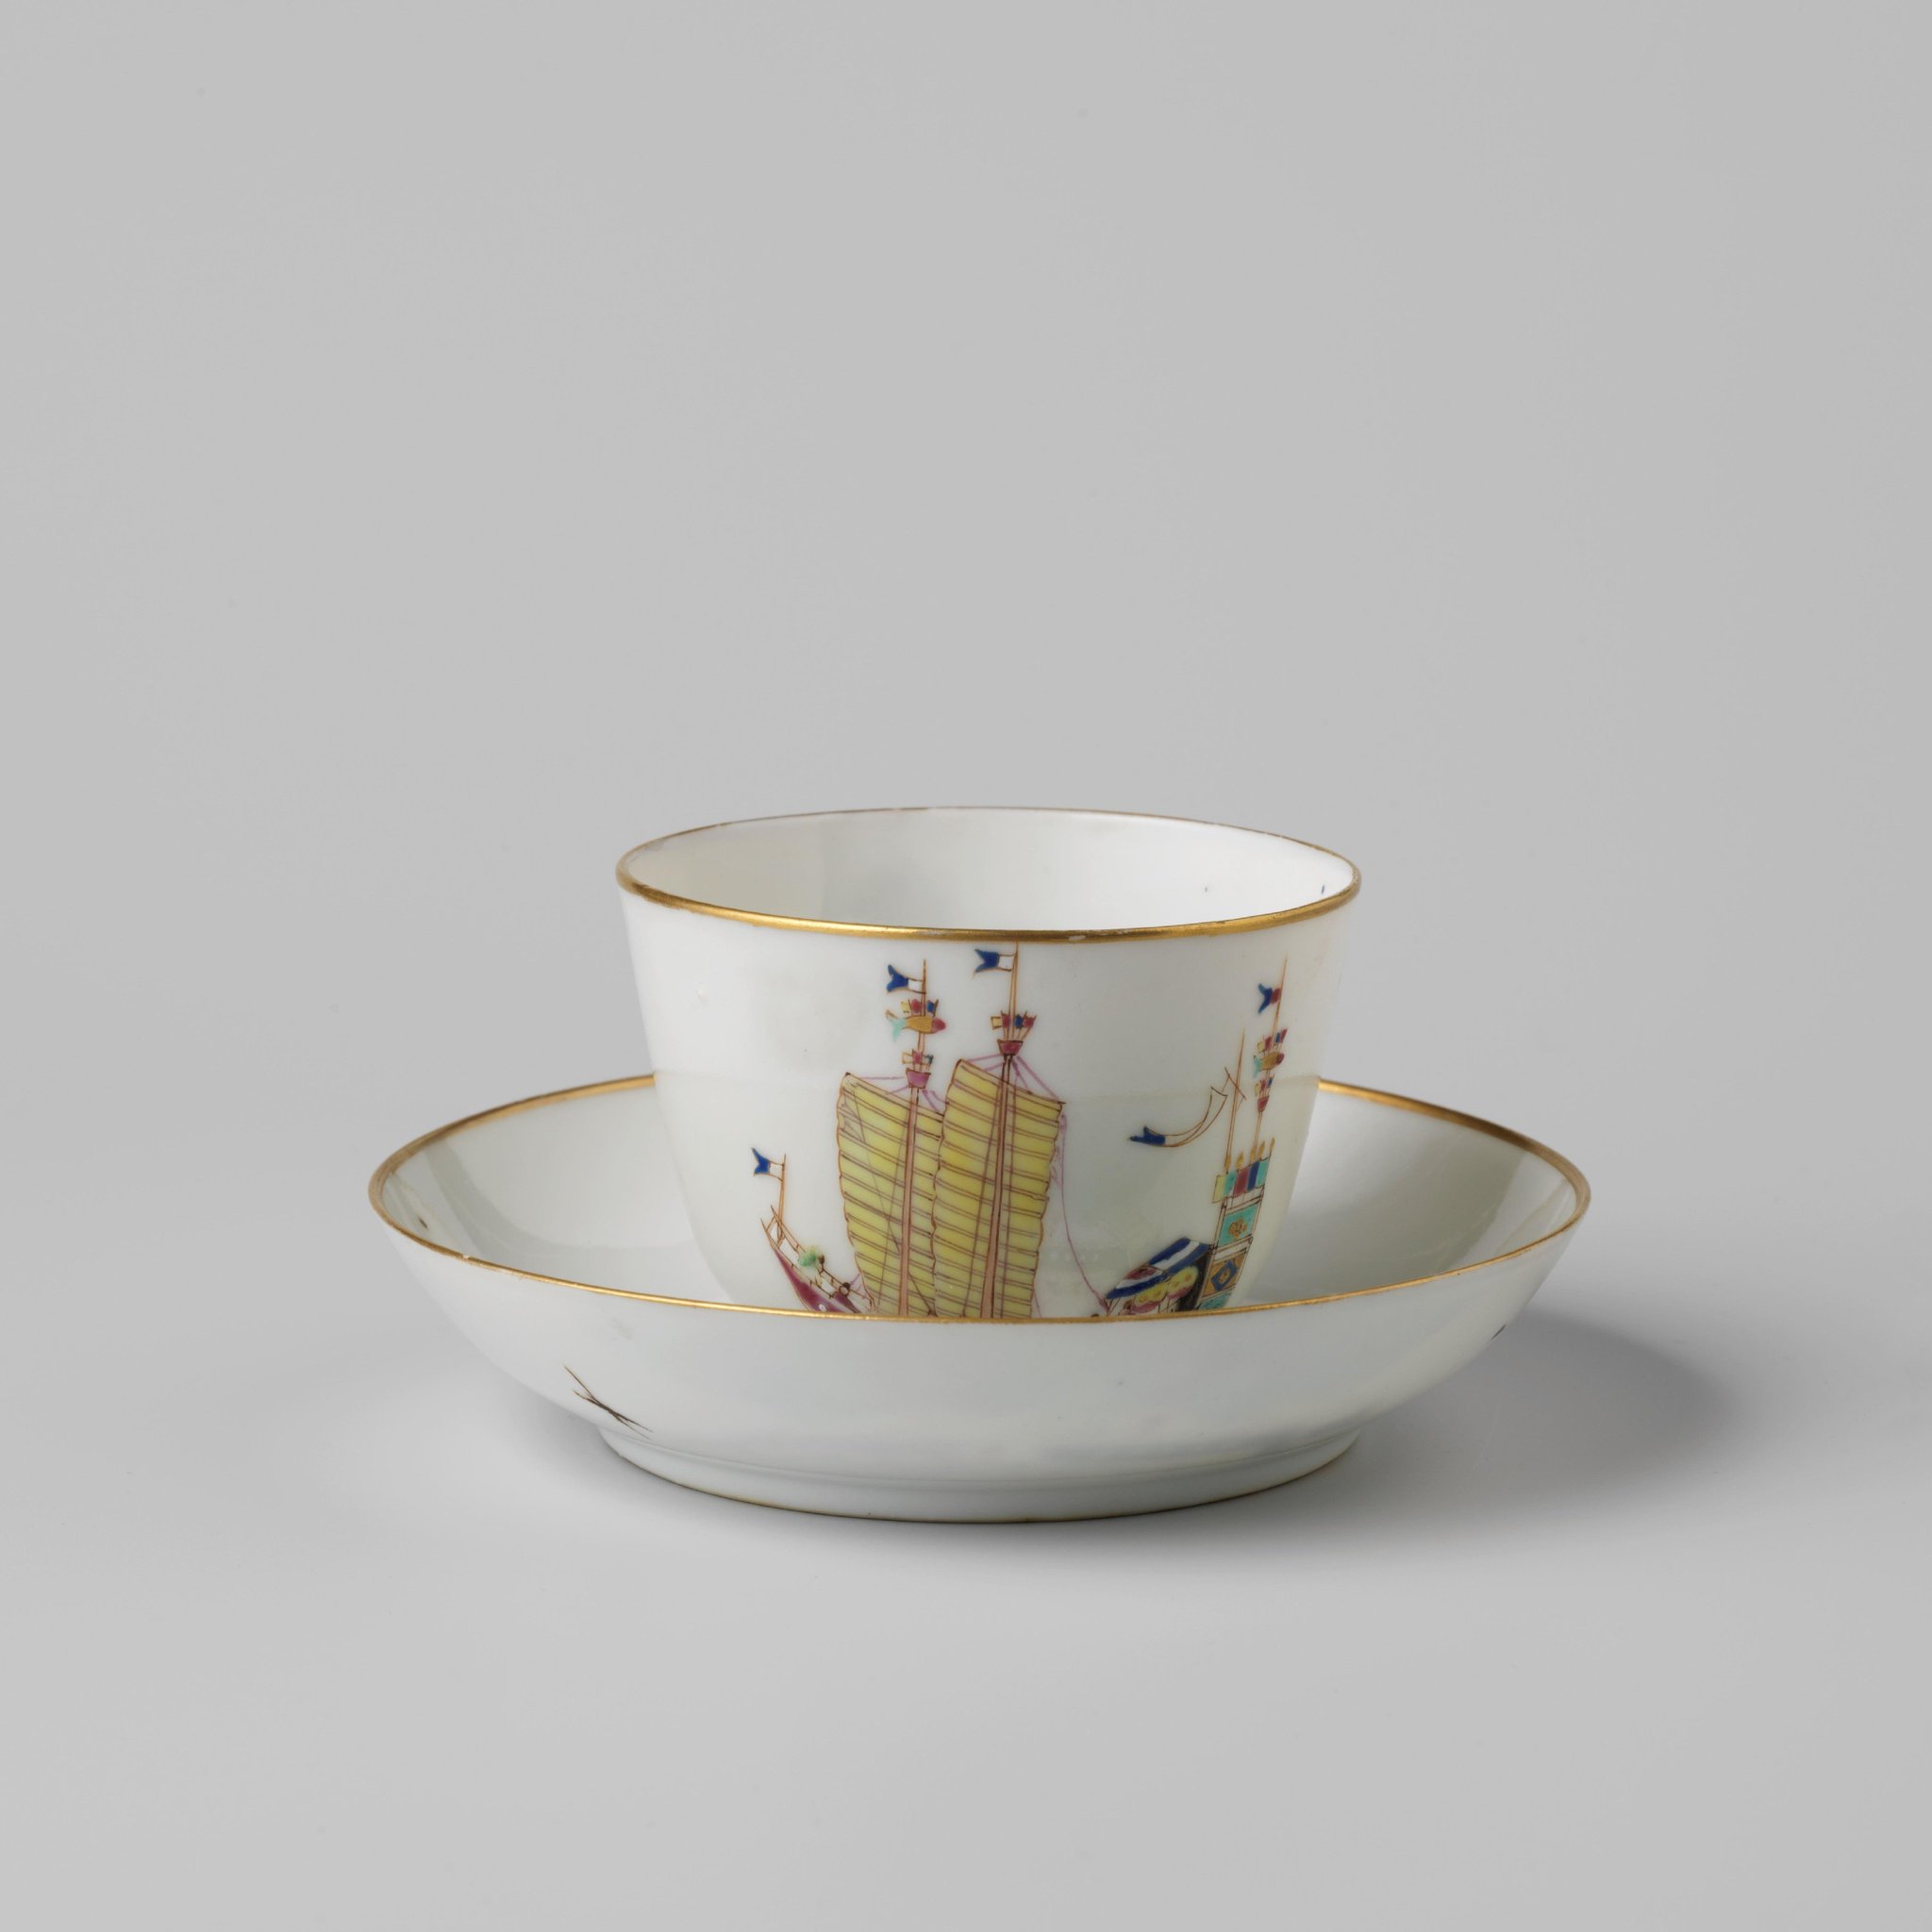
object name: kop en schotel, kop en schotel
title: Cup and saucer with a Chinese junk and the arms of Amsterdam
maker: Anonymous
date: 1800-1899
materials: glaze, gold, paint, porcelain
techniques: firing, gilding, turning, vitrification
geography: china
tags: china, amsterdam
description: Kop en schotel van porselein, beschilderd op het glazuur in blauw, rood, roze, groen, geel, zwart en goud. Op de voorzijde van de schotel een Chinese jonk met bemanning op de golven, daarboven het wapen van Amsterdam. De kop met dezelfde decoratie. Wapenporselein.